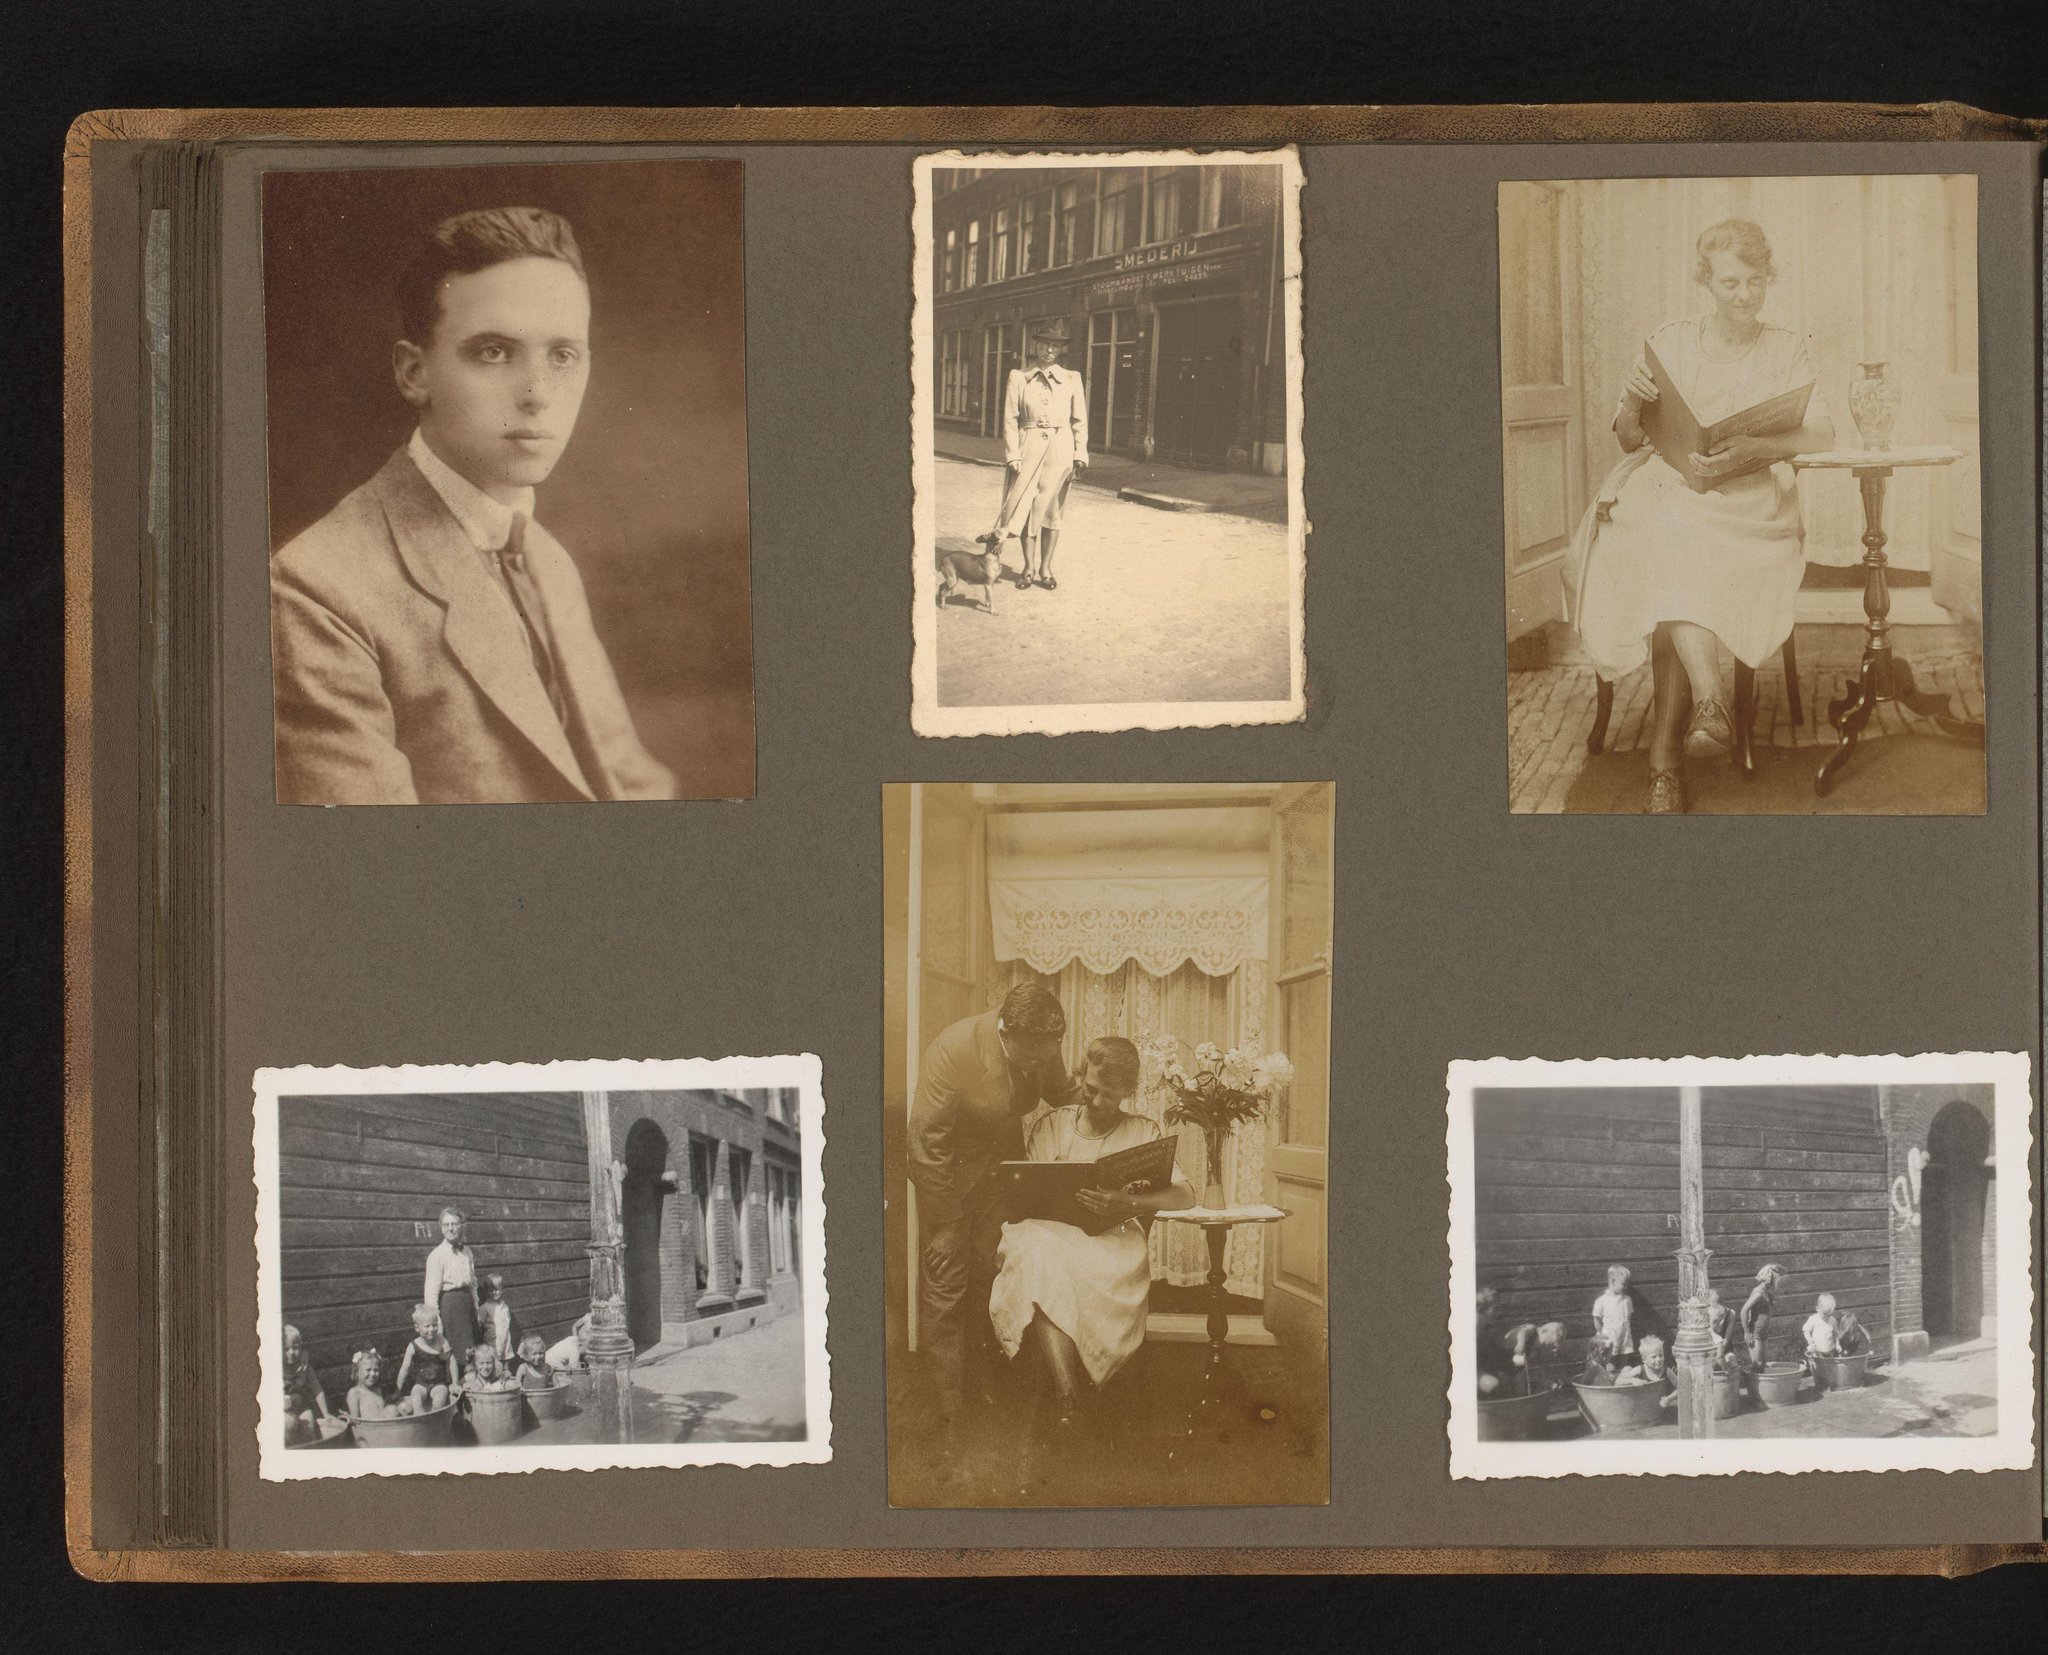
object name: photograph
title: Diverse afbeeldingen waaronder portretten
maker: Anonymous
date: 1900-1950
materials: photographic support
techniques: gelatin silver print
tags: adult woman, reading, tub-bath, adult man, historical persons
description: Portret van een man, een vrouw met hond op straat, een lezende vrouw, een lezende vrouw met man en twee foto's van kinderen in tobbes. Deze pagina maakt deel uit van een album.